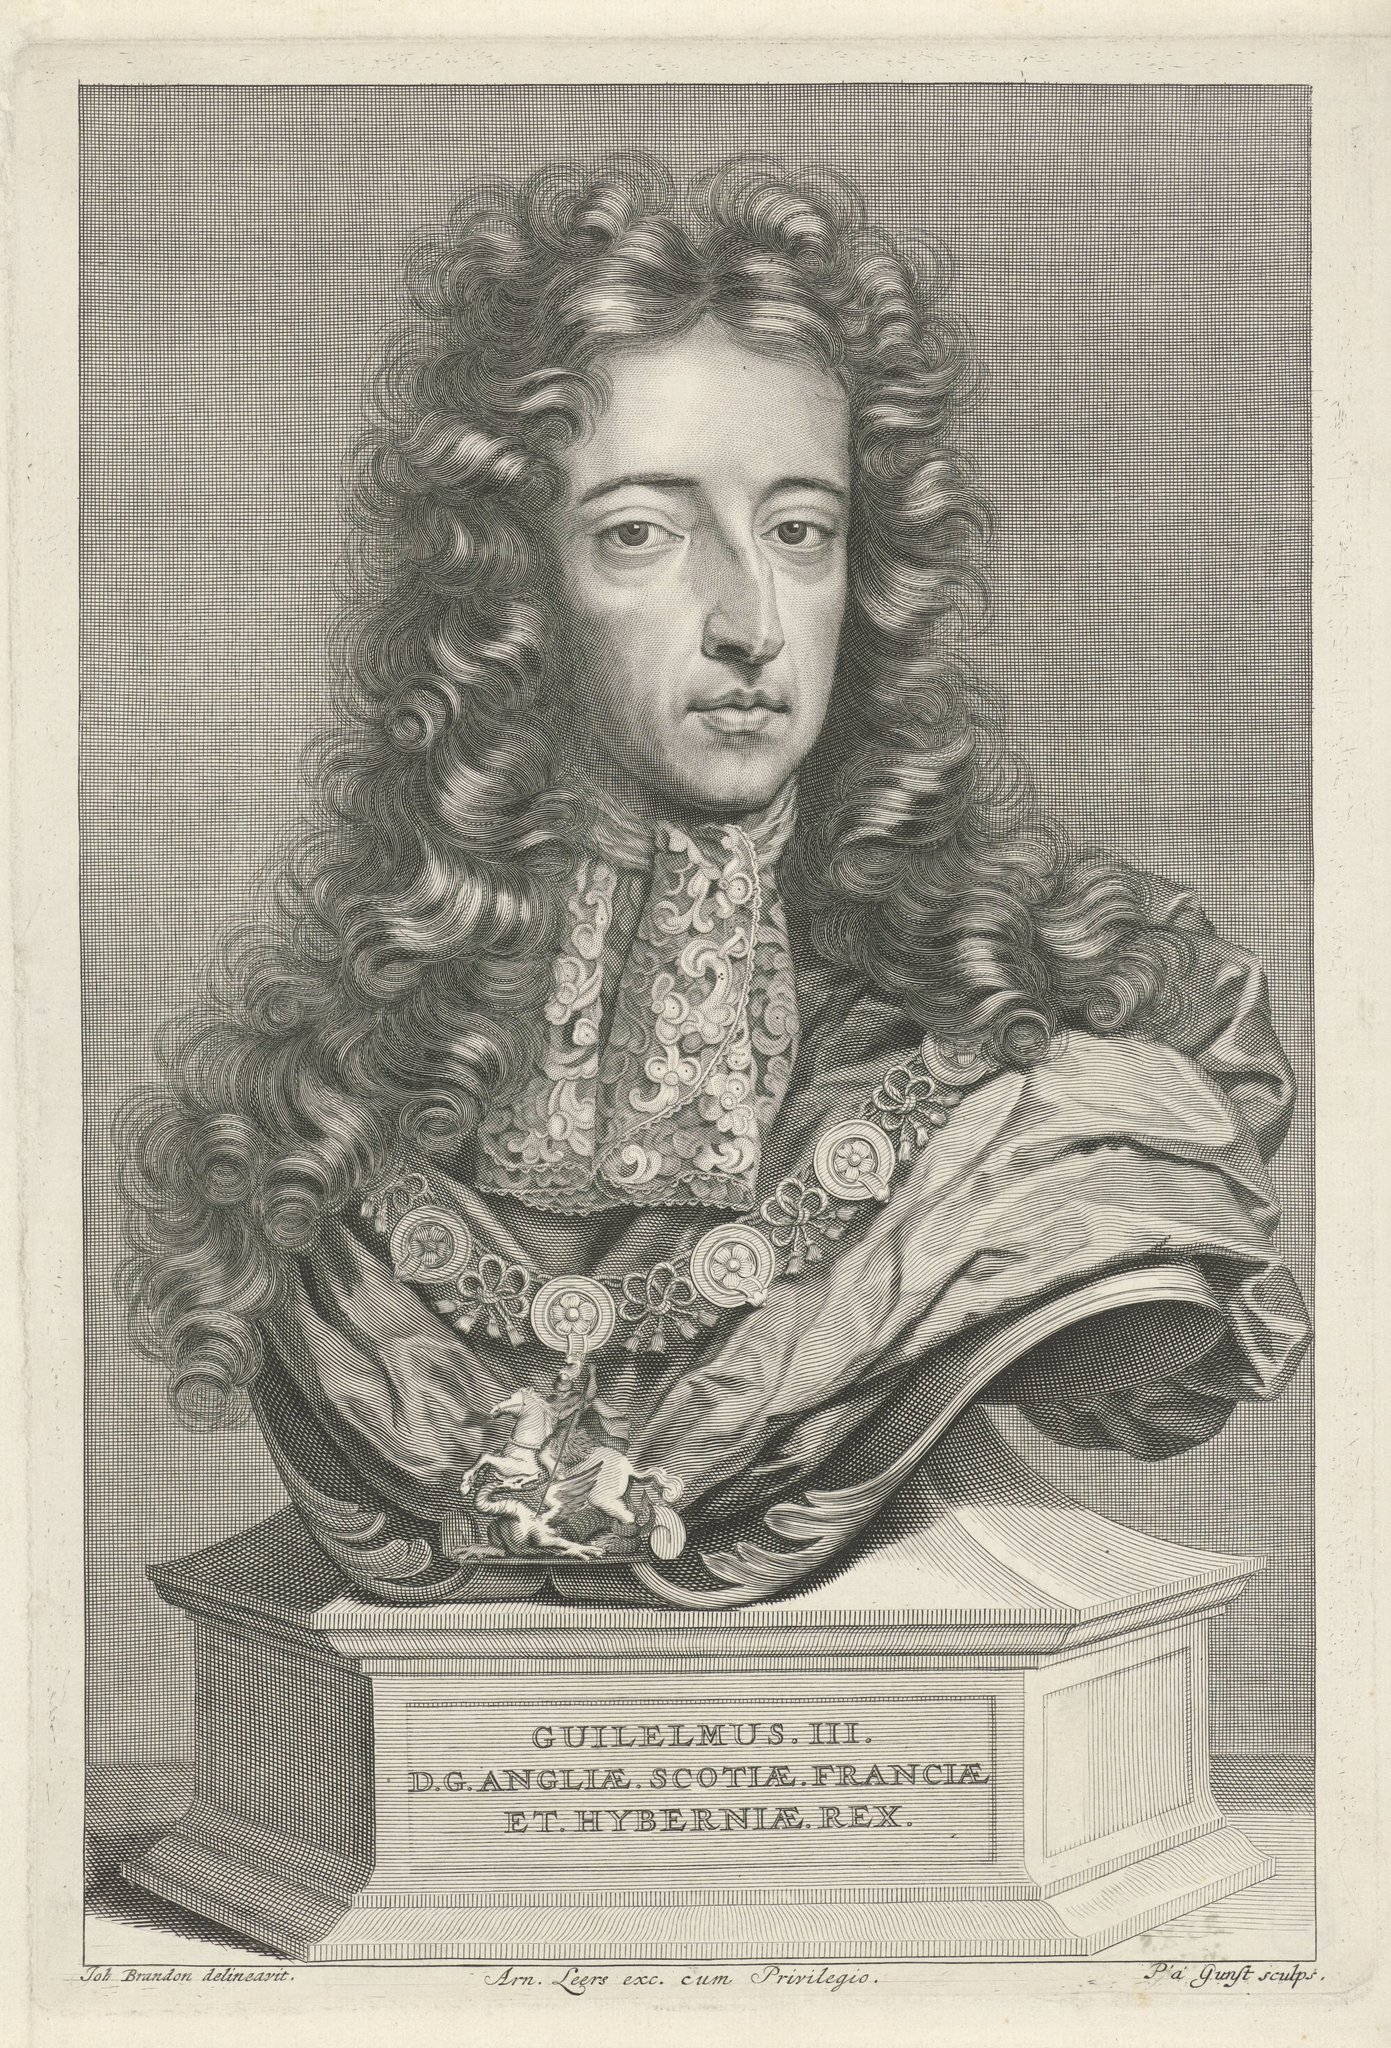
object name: print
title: Portret van Willem III, prins van Oranje-Nassau, koning van Engeland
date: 1689-1731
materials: paper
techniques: engraving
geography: amsterdam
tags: the hague, william iii (prince of orange and king of england, scotland, and ireland), knighthood order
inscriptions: collector's mark: Lugt 2166, collector's mark: Lugt 963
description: Borstbeeld van Willem III, prins van Oranje-Nassau, koning van Engeland. Hij draagt het ordeteken van de Kousenband.